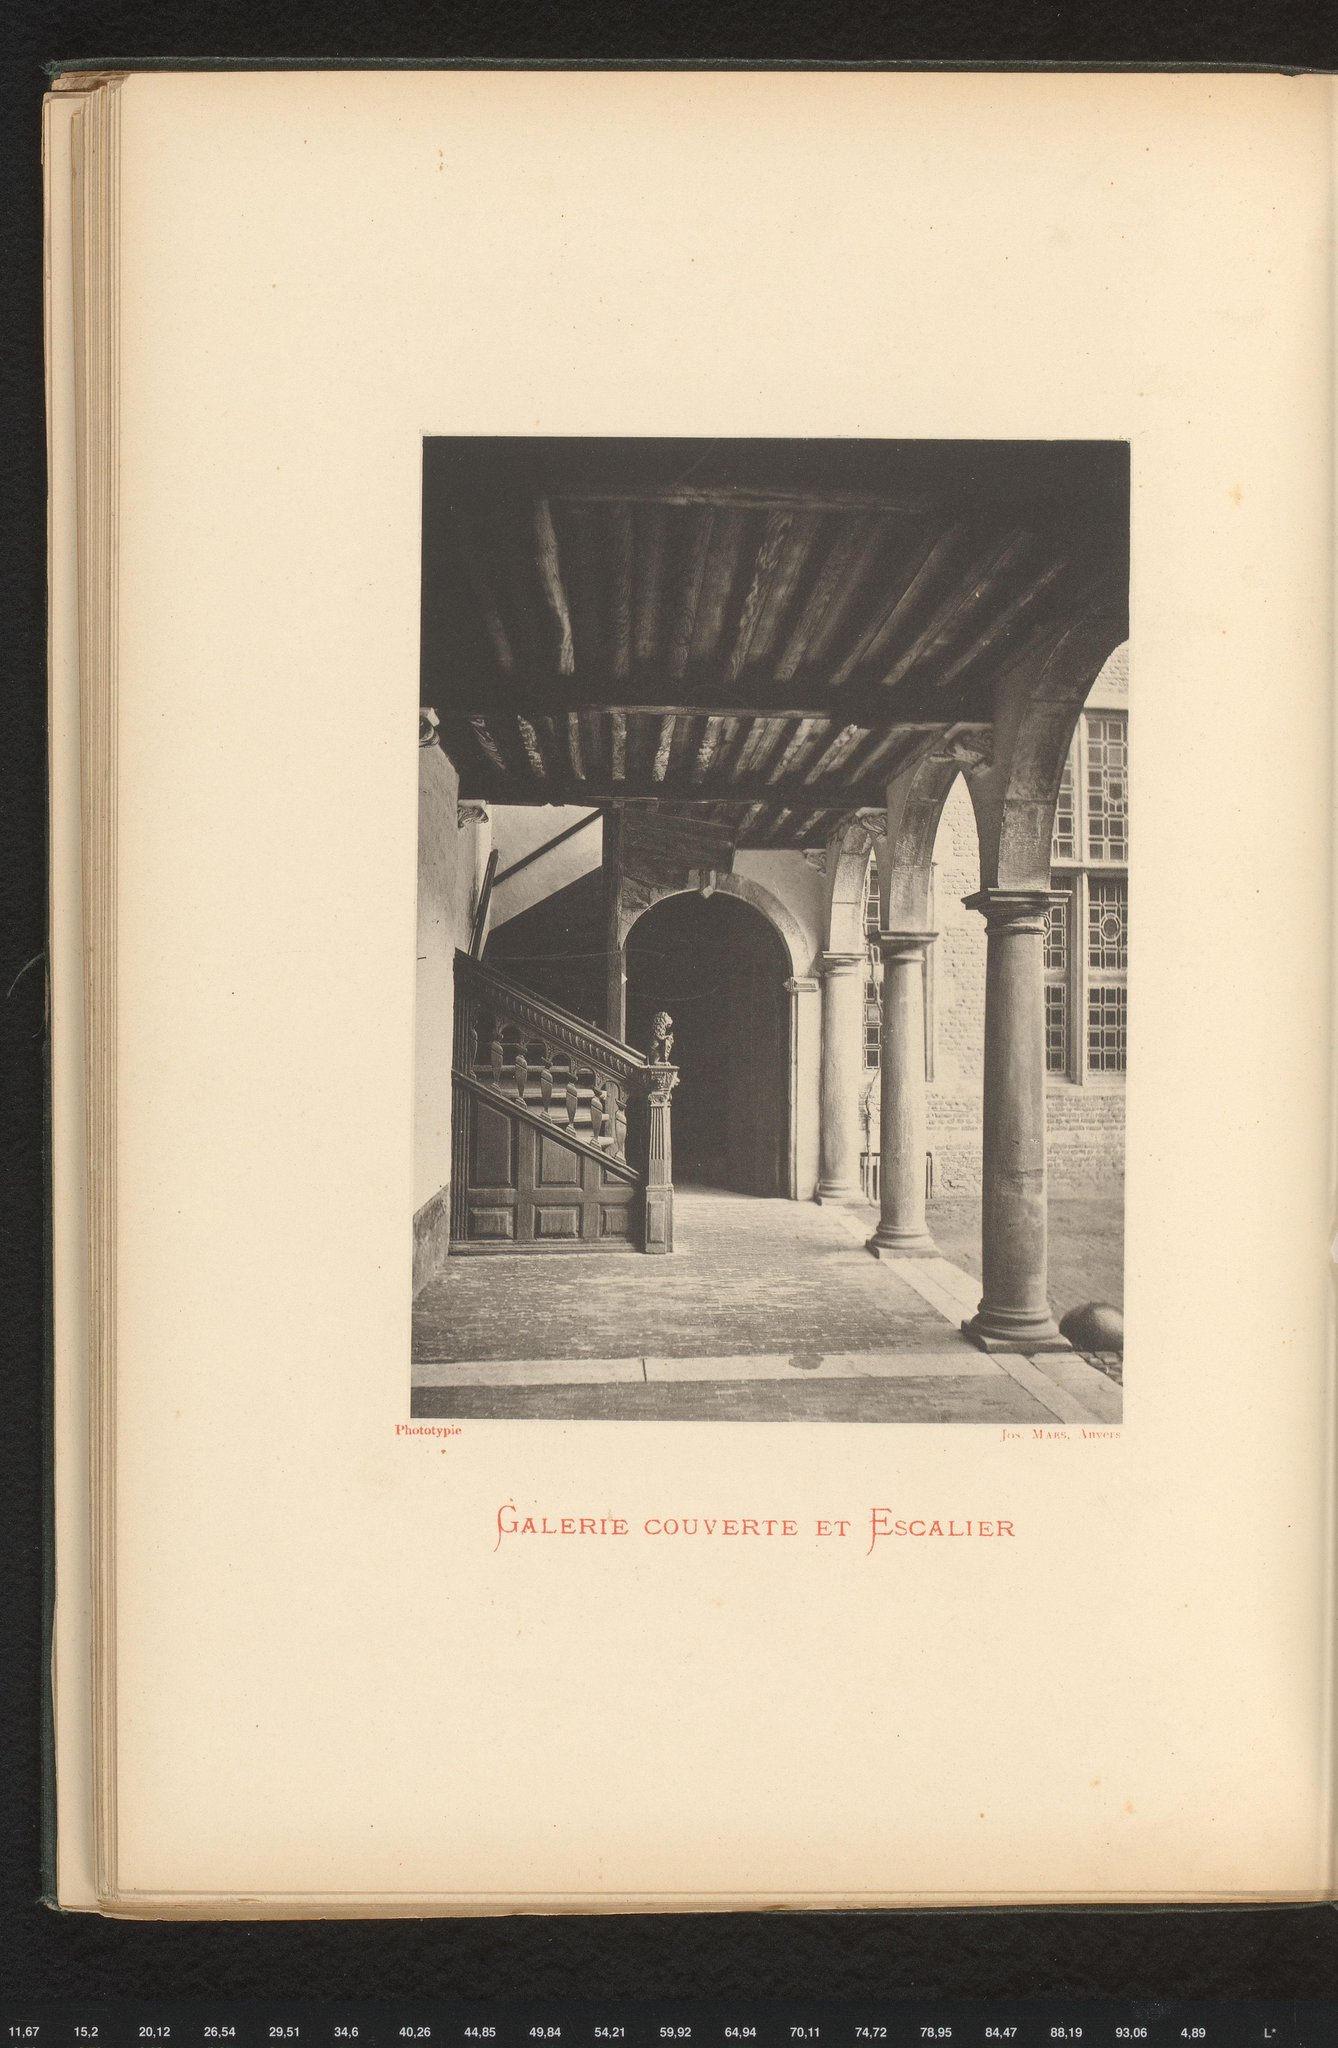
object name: photomechanical print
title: Galere couverte et escalier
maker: joseph maes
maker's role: fotograaf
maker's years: 1838-1908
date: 1877-1882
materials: paper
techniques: photograph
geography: antwerp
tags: corridor, staircase